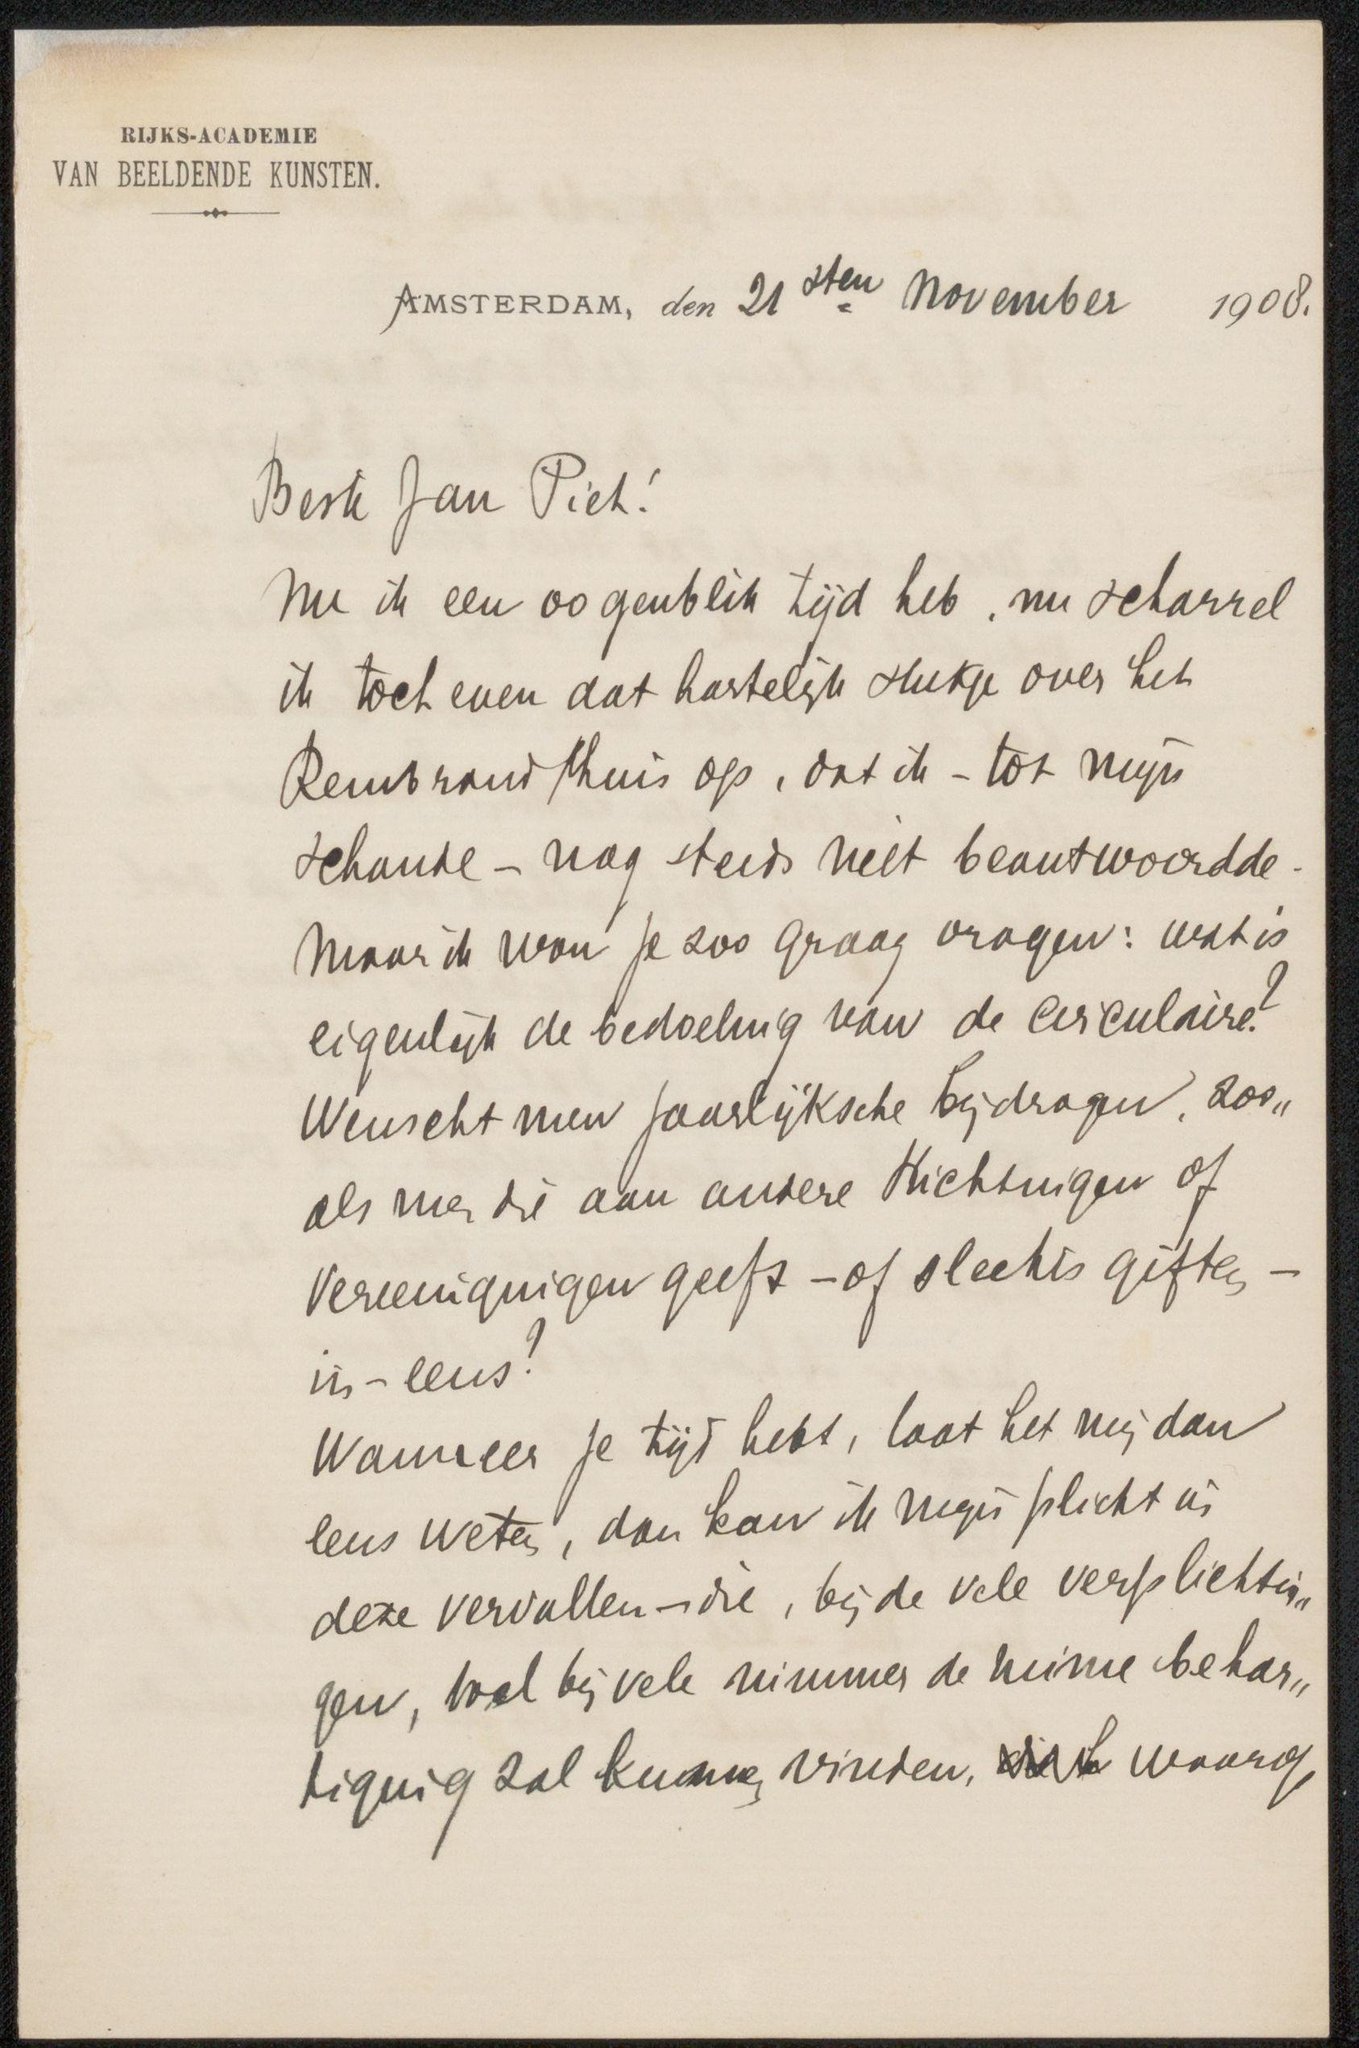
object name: letter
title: Brief aan Jan Veth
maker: antoon derkinderen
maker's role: draughtsman, painter, print maker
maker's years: 1859-1925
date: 1908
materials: ink, paper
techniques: pen, printing, writing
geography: amsterdam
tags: august allebé, dordrecht, painter, designer, jan veth, den helder, amsterdam, print maker, draughtsman, karel petrus cornelis de bazel, historical persons (portraits and scenes from the life)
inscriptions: collector's mark: ‘RPK’